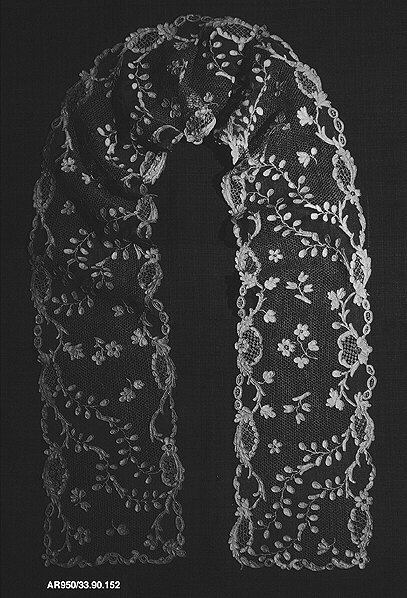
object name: cravat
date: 1734-1766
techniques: lace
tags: flowers